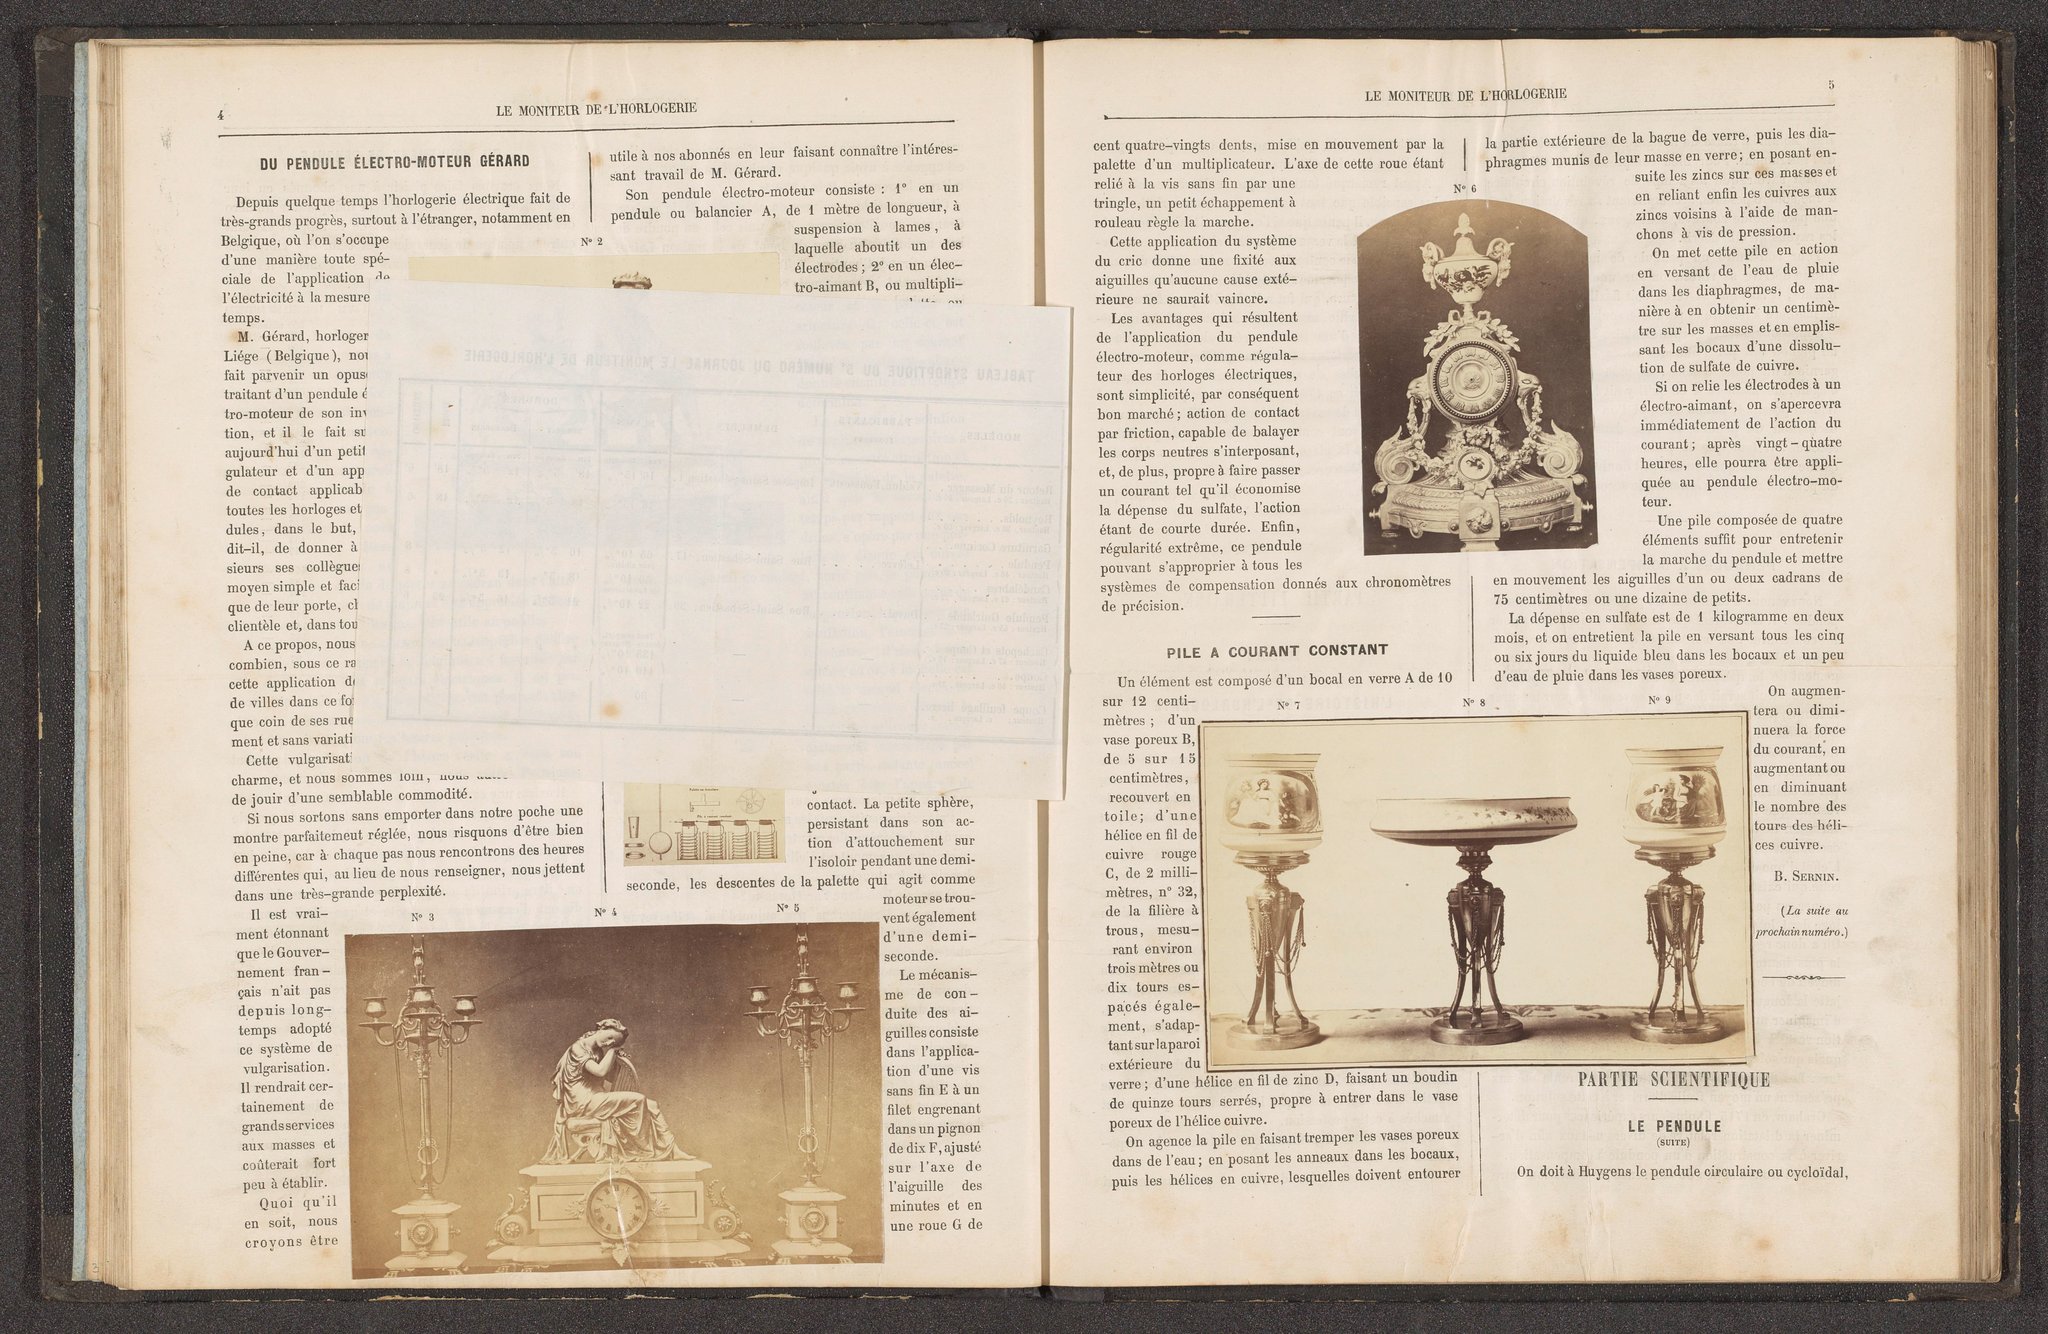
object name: photograph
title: Klok en drie vazen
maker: Anonymous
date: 1857-1867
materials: photographic support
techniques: albumen print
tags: clock, container of ceramics: jar, jug, pot, vase, ornament derived from plant forms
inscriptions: number: ‘No 6 No 7 No 8 No 9’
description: Boven: klok gedecoreerd met voluten en guirlandes door M. Duval, onder: drie vazen gedecoreerd met bladmotieven en vrouwen.